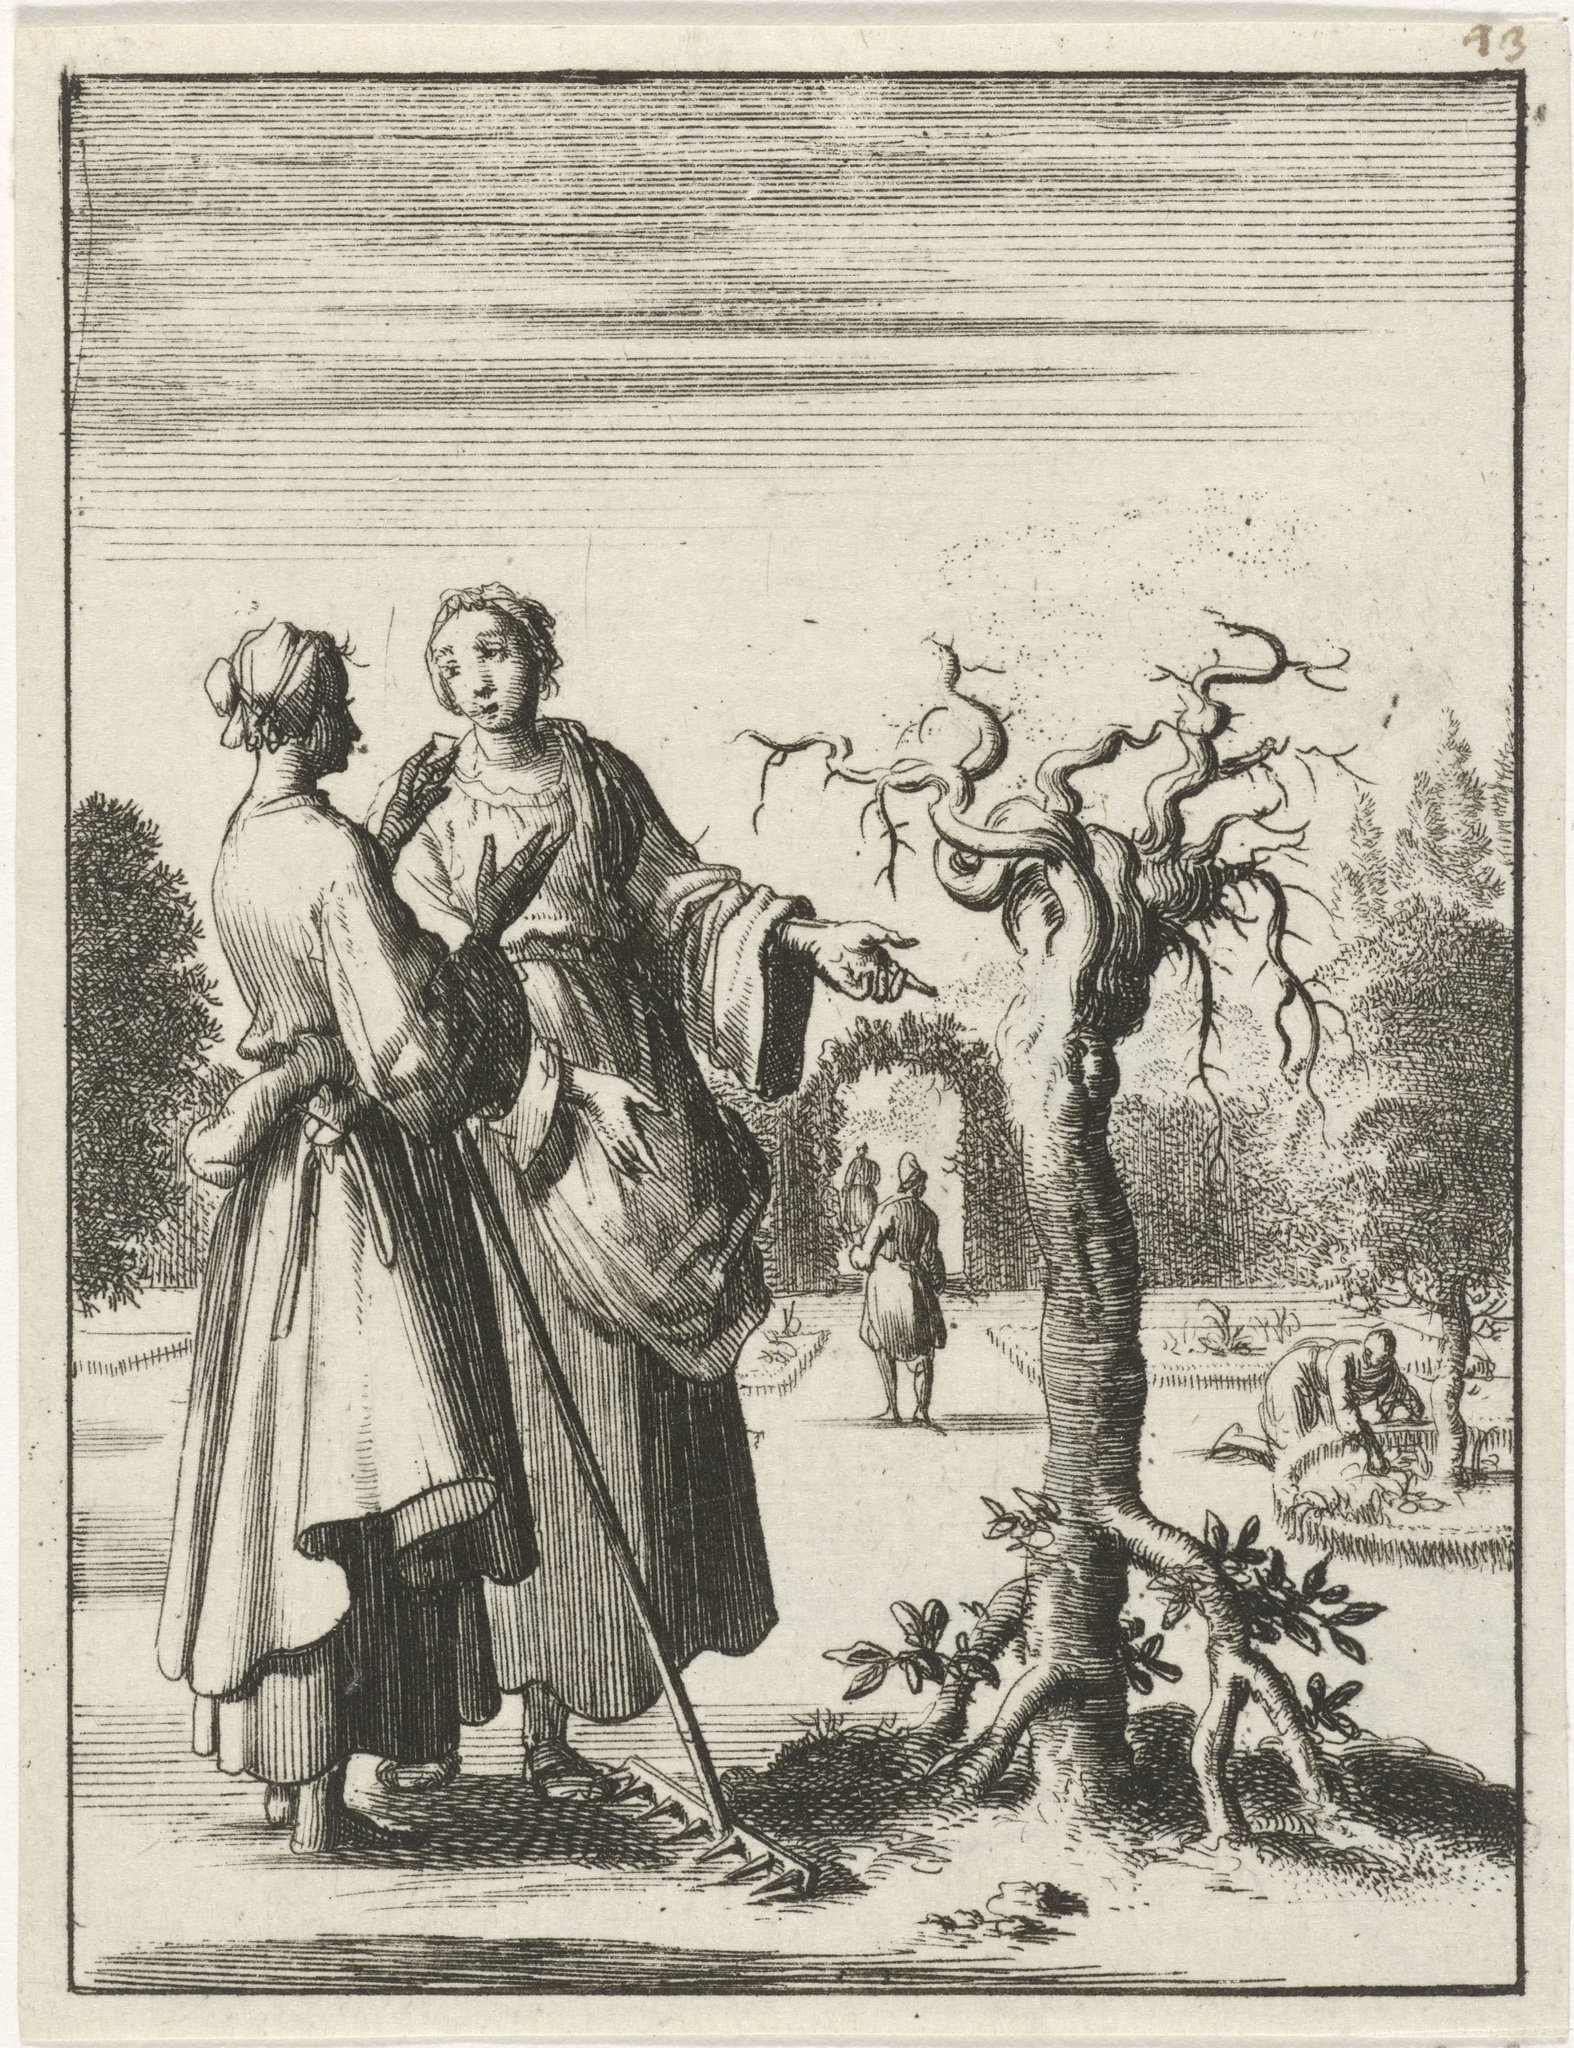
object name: print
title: Twee vrouwen bekijken een boom die met de wortels omhoog is geplant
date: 1687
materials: paper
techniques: etching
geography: amsterdam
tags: trees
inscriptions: collector's mark: Lugt 2228, number: ‘43’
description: Illustratie uit: Luyken, Jan. Voncken der liefde Jesu, van het godtbegerende zielenvier. Amsterdam: Pieter Arentsz (II), 1687, p. 182.